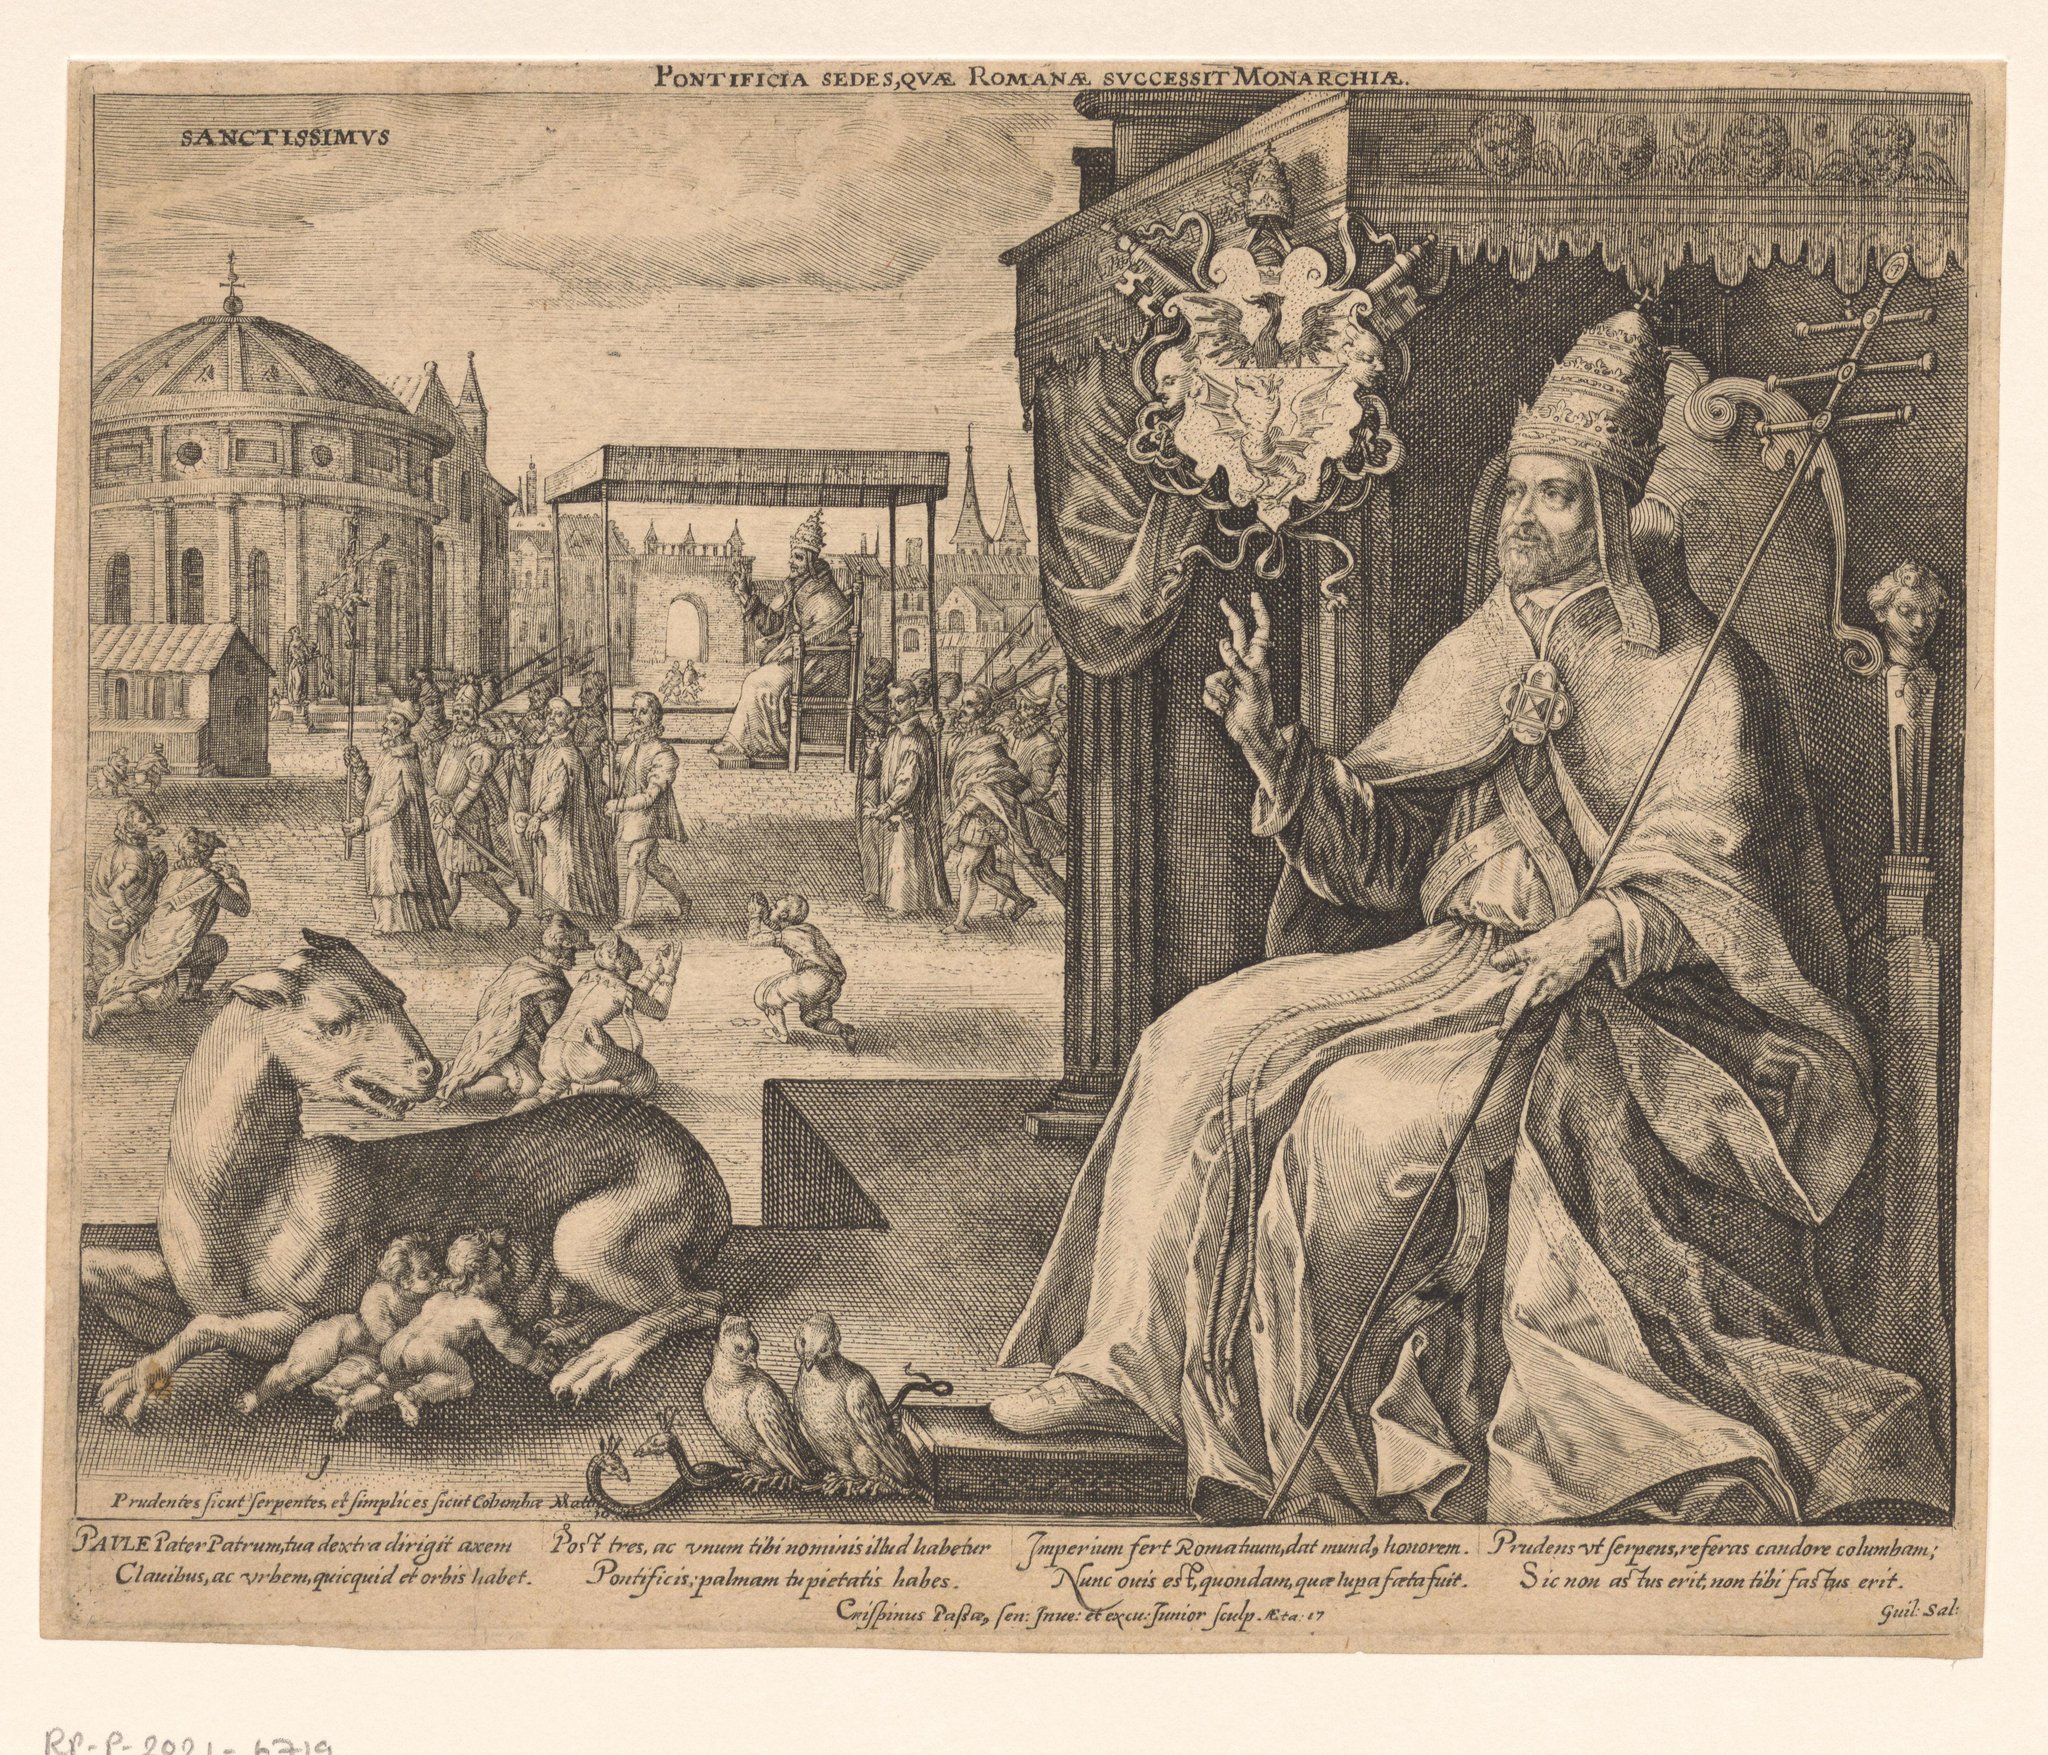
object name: print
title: Portret van paus Paulus V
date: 1611-1614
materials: paper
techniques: engraving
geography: utrecht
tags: paulus v, romulus and remus are washed ashore and suckled by a she-wolf; 'lupa romana', adult man, historical persons, pope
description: Paus Paulus V op een troon onder een baldakijn. In zijn linkerhand houdt hij een kruisstaf en met zijn rechterhand maakt hij een zegenend gebaar. Naast hem zijn wapenschild. Aan zijn voeten liggen twee slangen en zitten twee duiven. Links op de voorgrond ligt de wolvin die de tweeling Romulus en Remus zoogt. Op de achtergrond de feestelijke intocht van paus Paulus V. Linksonder een Bijbelcitaat uit Matt. 10 in het Latijn. In de marge een achtregelig lofdicht, in vier kolommen, in het Latijn.